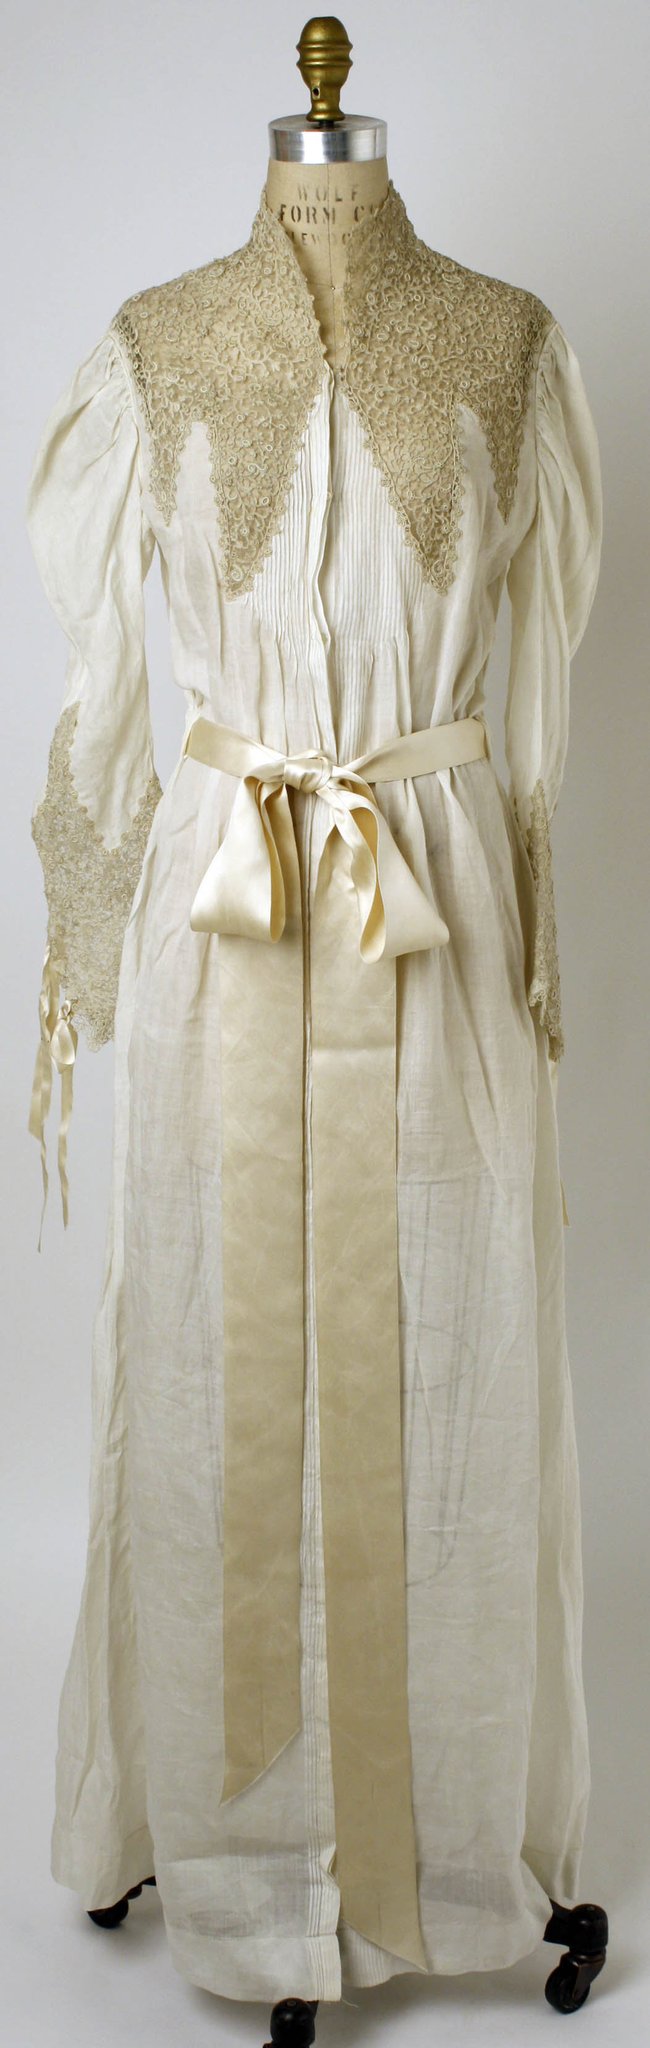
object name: nightgown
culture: french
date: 1890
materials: cotton